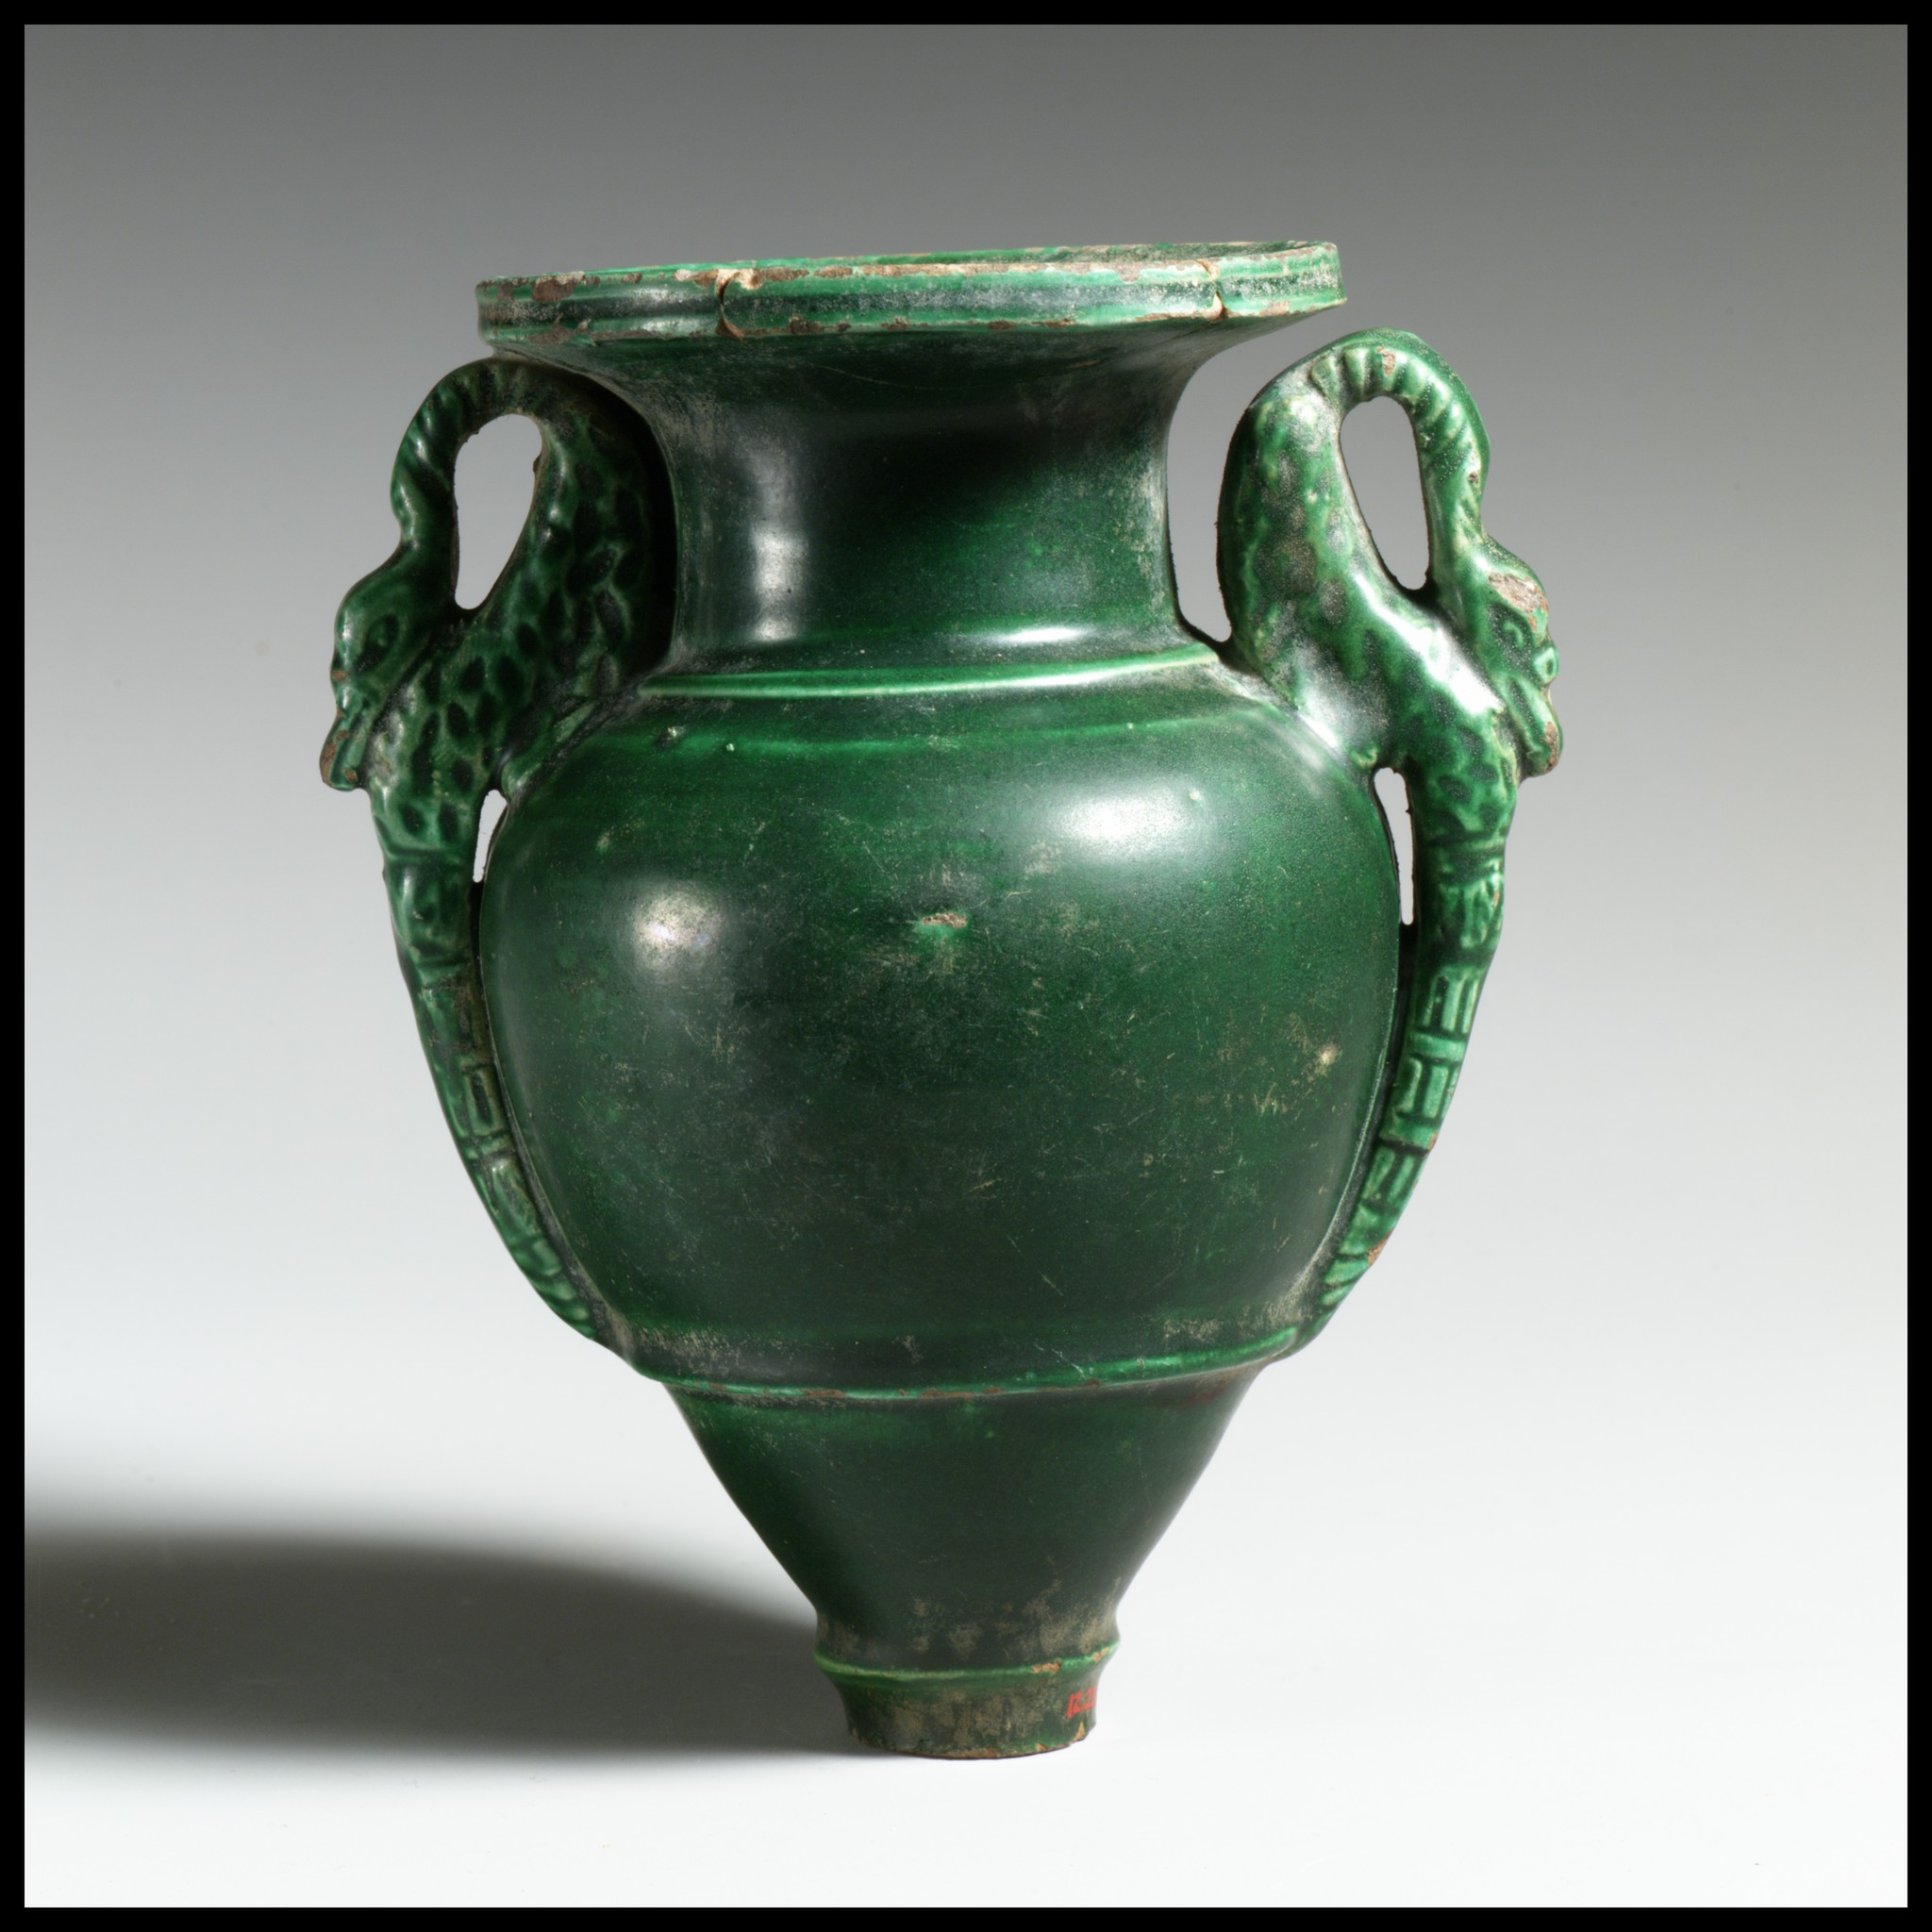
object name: amphora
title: Terracotta amphora (two-handled jar)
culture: roman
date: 67-100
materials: terracotta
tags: snakes